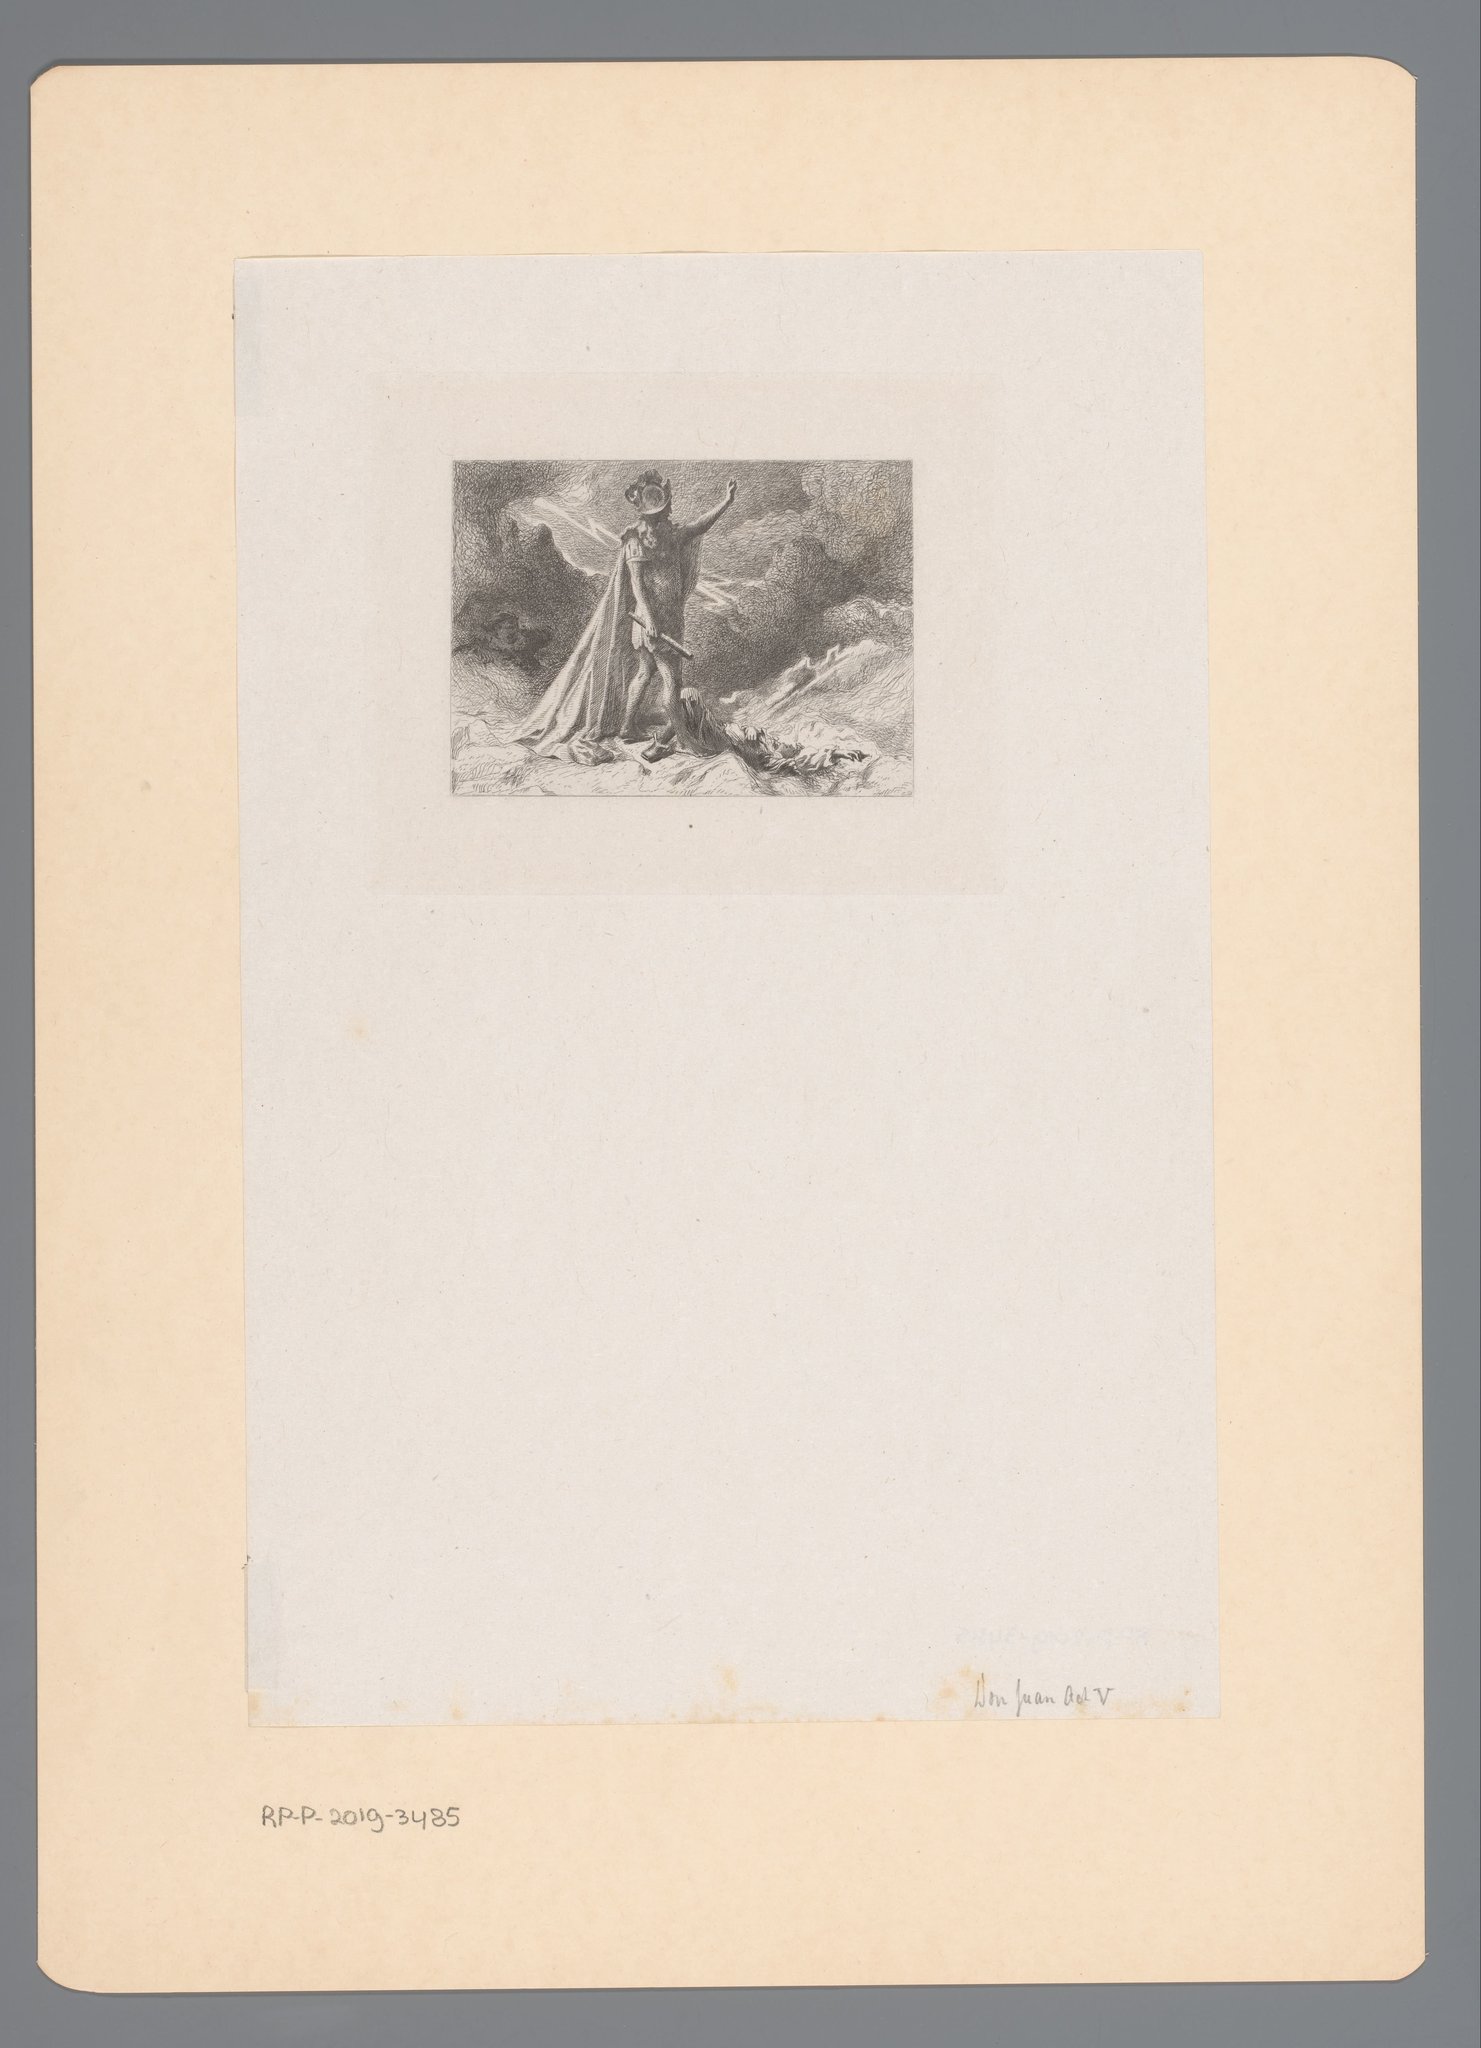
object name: print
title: Dood van Dom Juan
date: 1878-1879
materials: paper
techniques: drypoint, etching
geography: tours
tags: theatre, theatrical performance, hell and purgatory, sculpture, death of human being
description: Akte V, scène VI uit "Dom Juan" van Molière. Het standbeeld van de commandeur met aan zijn voeten de gestorven Dom Juan, omringd door bliksem en vuur.